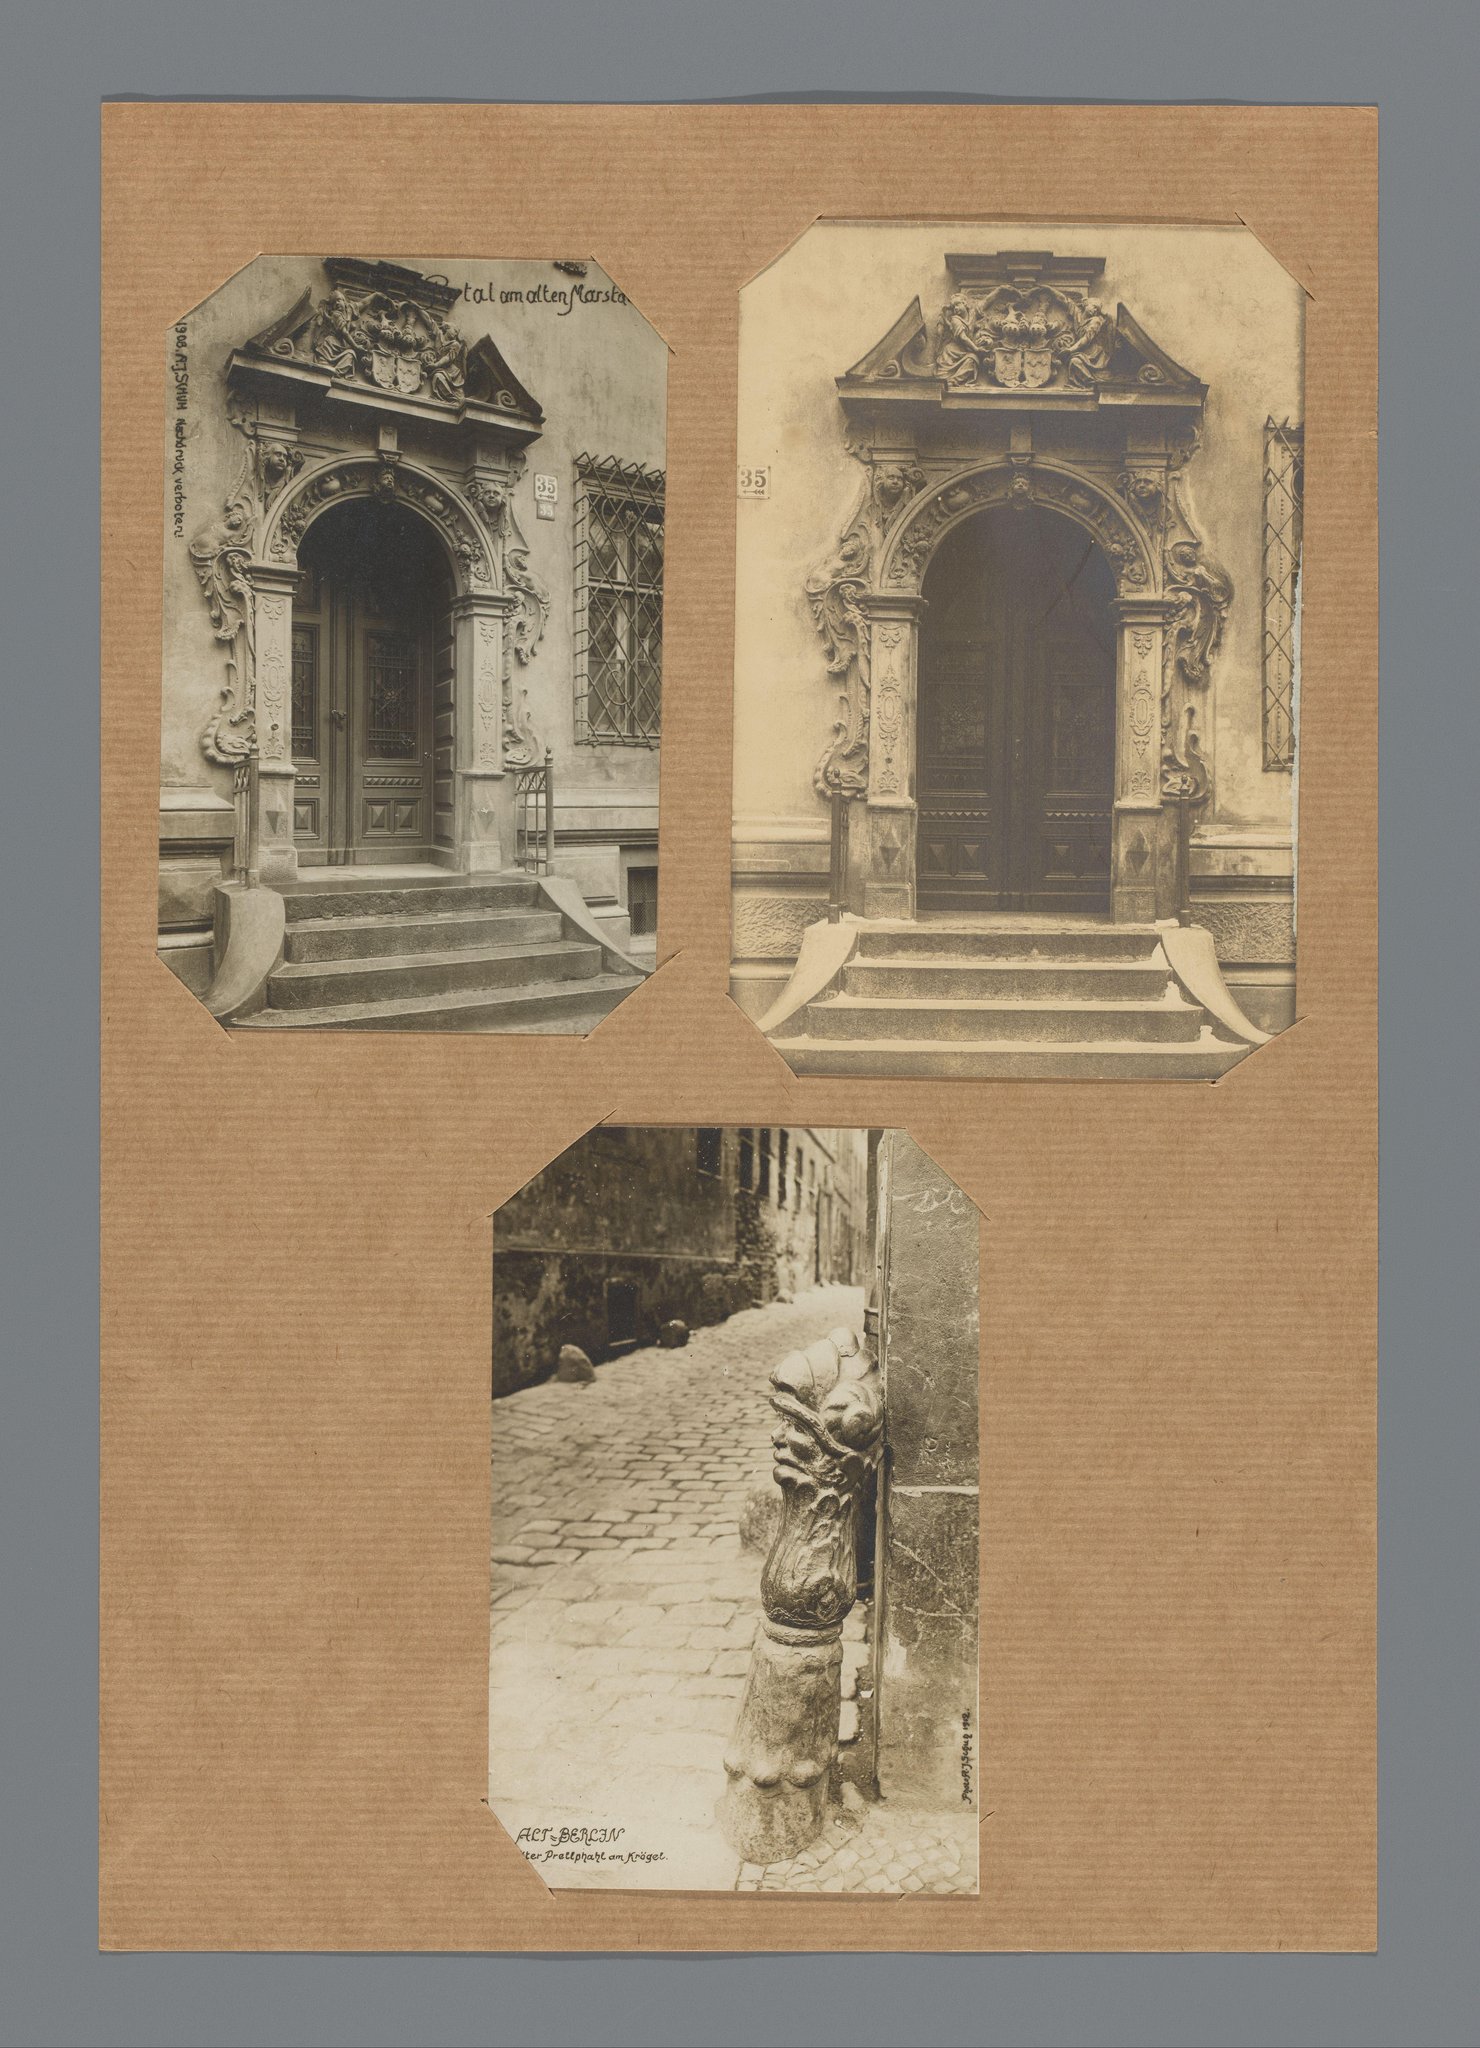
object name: photograph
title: Berlijn. Woonhuizen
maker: Anonymous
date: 1900-1950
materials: photographic support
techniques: gelatin silver print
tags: berlin